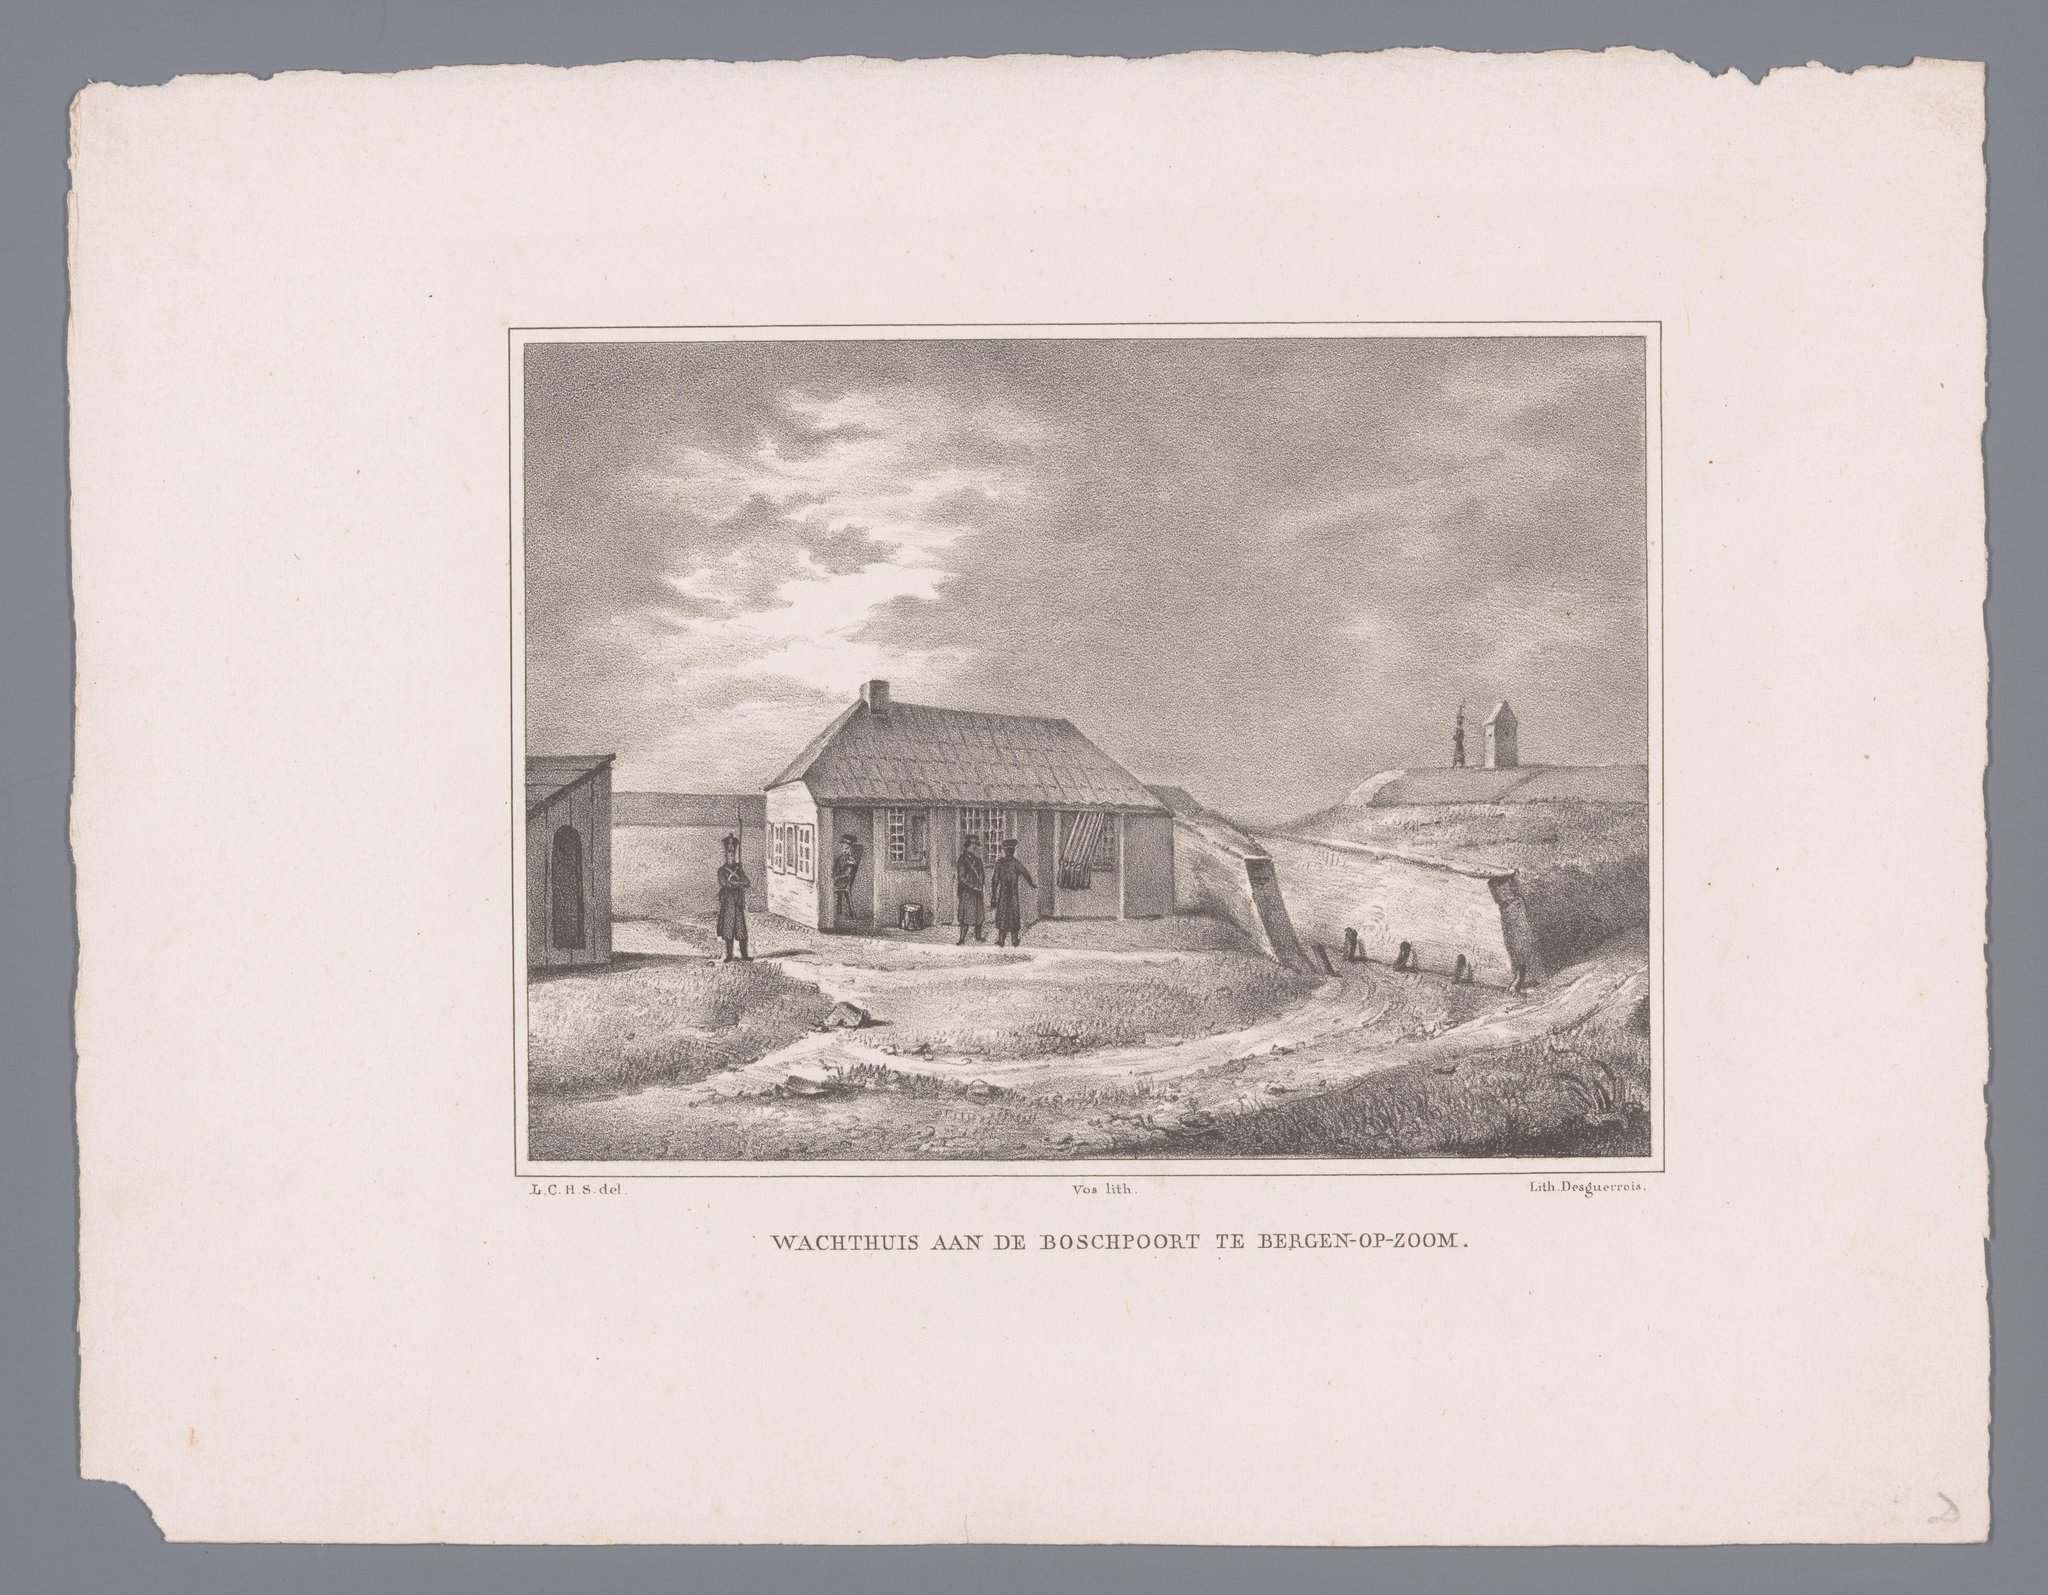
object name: print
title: Wachthuis aan de Bospoort in Bergen op Zoom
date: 1832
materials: paper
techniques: lithograph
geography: utrecht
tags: barracks, guard duty, keeping sentry, bergen op zoom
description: Prent uit: Utrechtsche studenten almanak voor het jaar 1832. Utrecht: J. van Schoonhoven en N. van der Monde, 1832, p. 100-101.